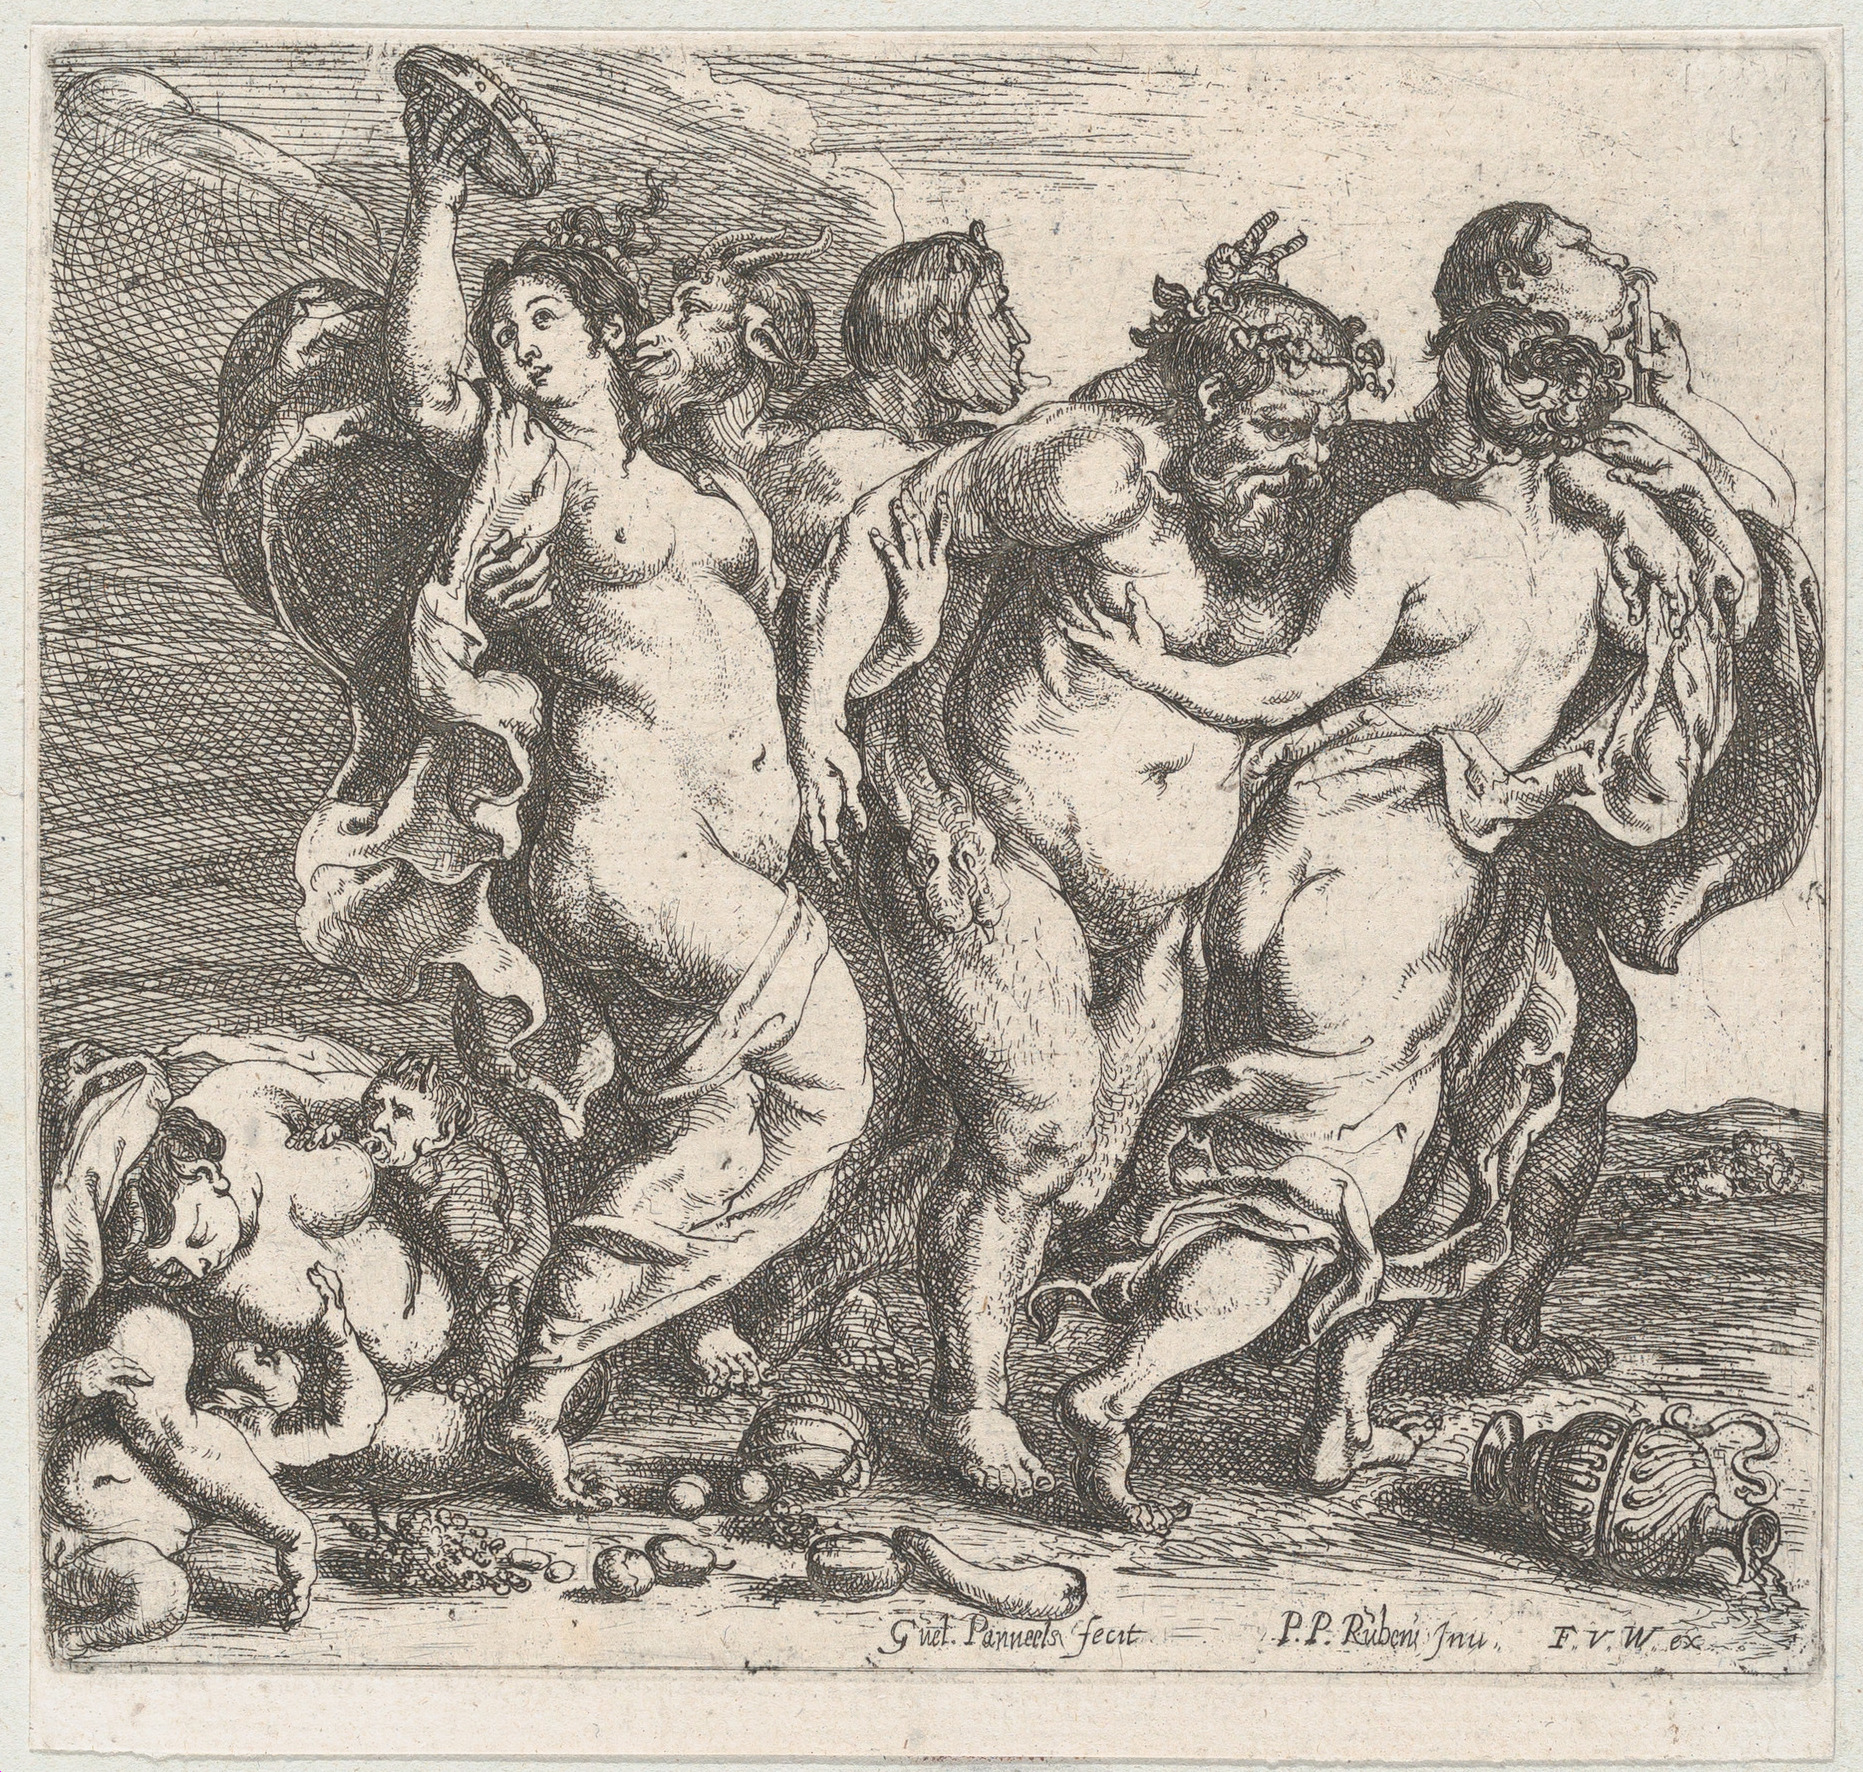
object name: print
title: The drunken Silenus, accompanied by nymphs and satyrs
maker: willem panneels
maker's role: artist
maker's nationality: flemish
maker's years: 1600-1632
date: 1632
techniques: etching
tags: silenus,nymphs,satyrs